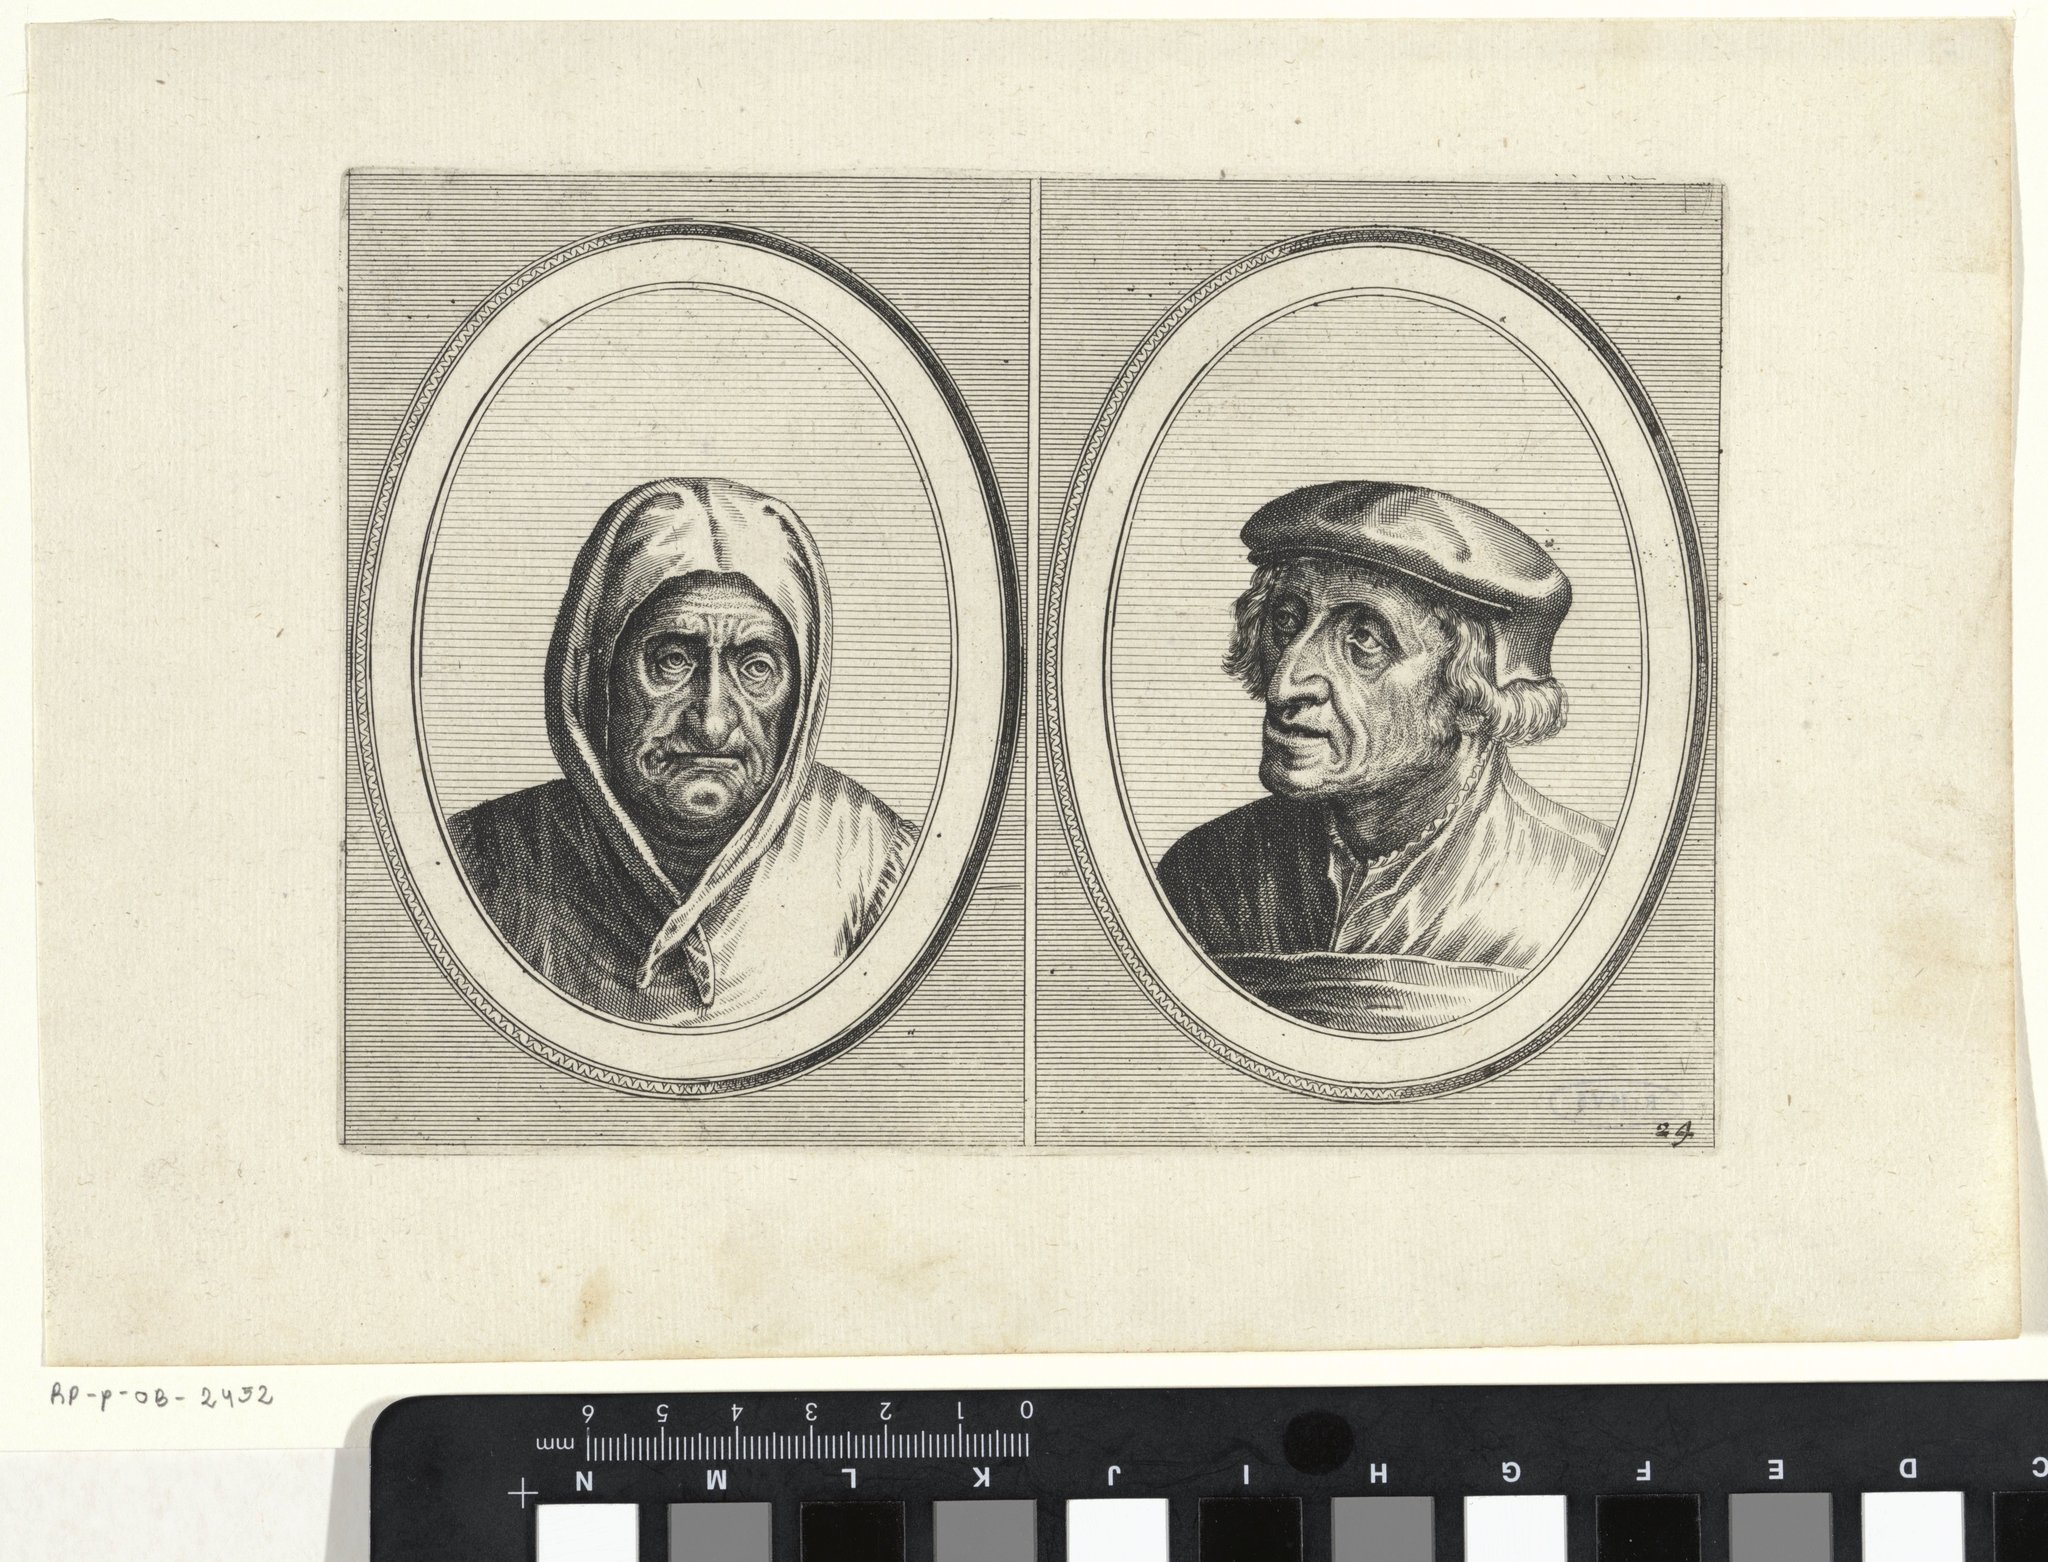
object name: print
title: Aecht Sonder-Ziel en Heertje Al-te-mooy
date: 1612-1652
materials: paper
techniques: engraving, etching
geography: amsterdam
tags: head-gear, farmers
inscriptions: collector's mark: Lugt 2228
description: Prent uit een serie van 36 prenten met koppen van boeren en boerinnen.